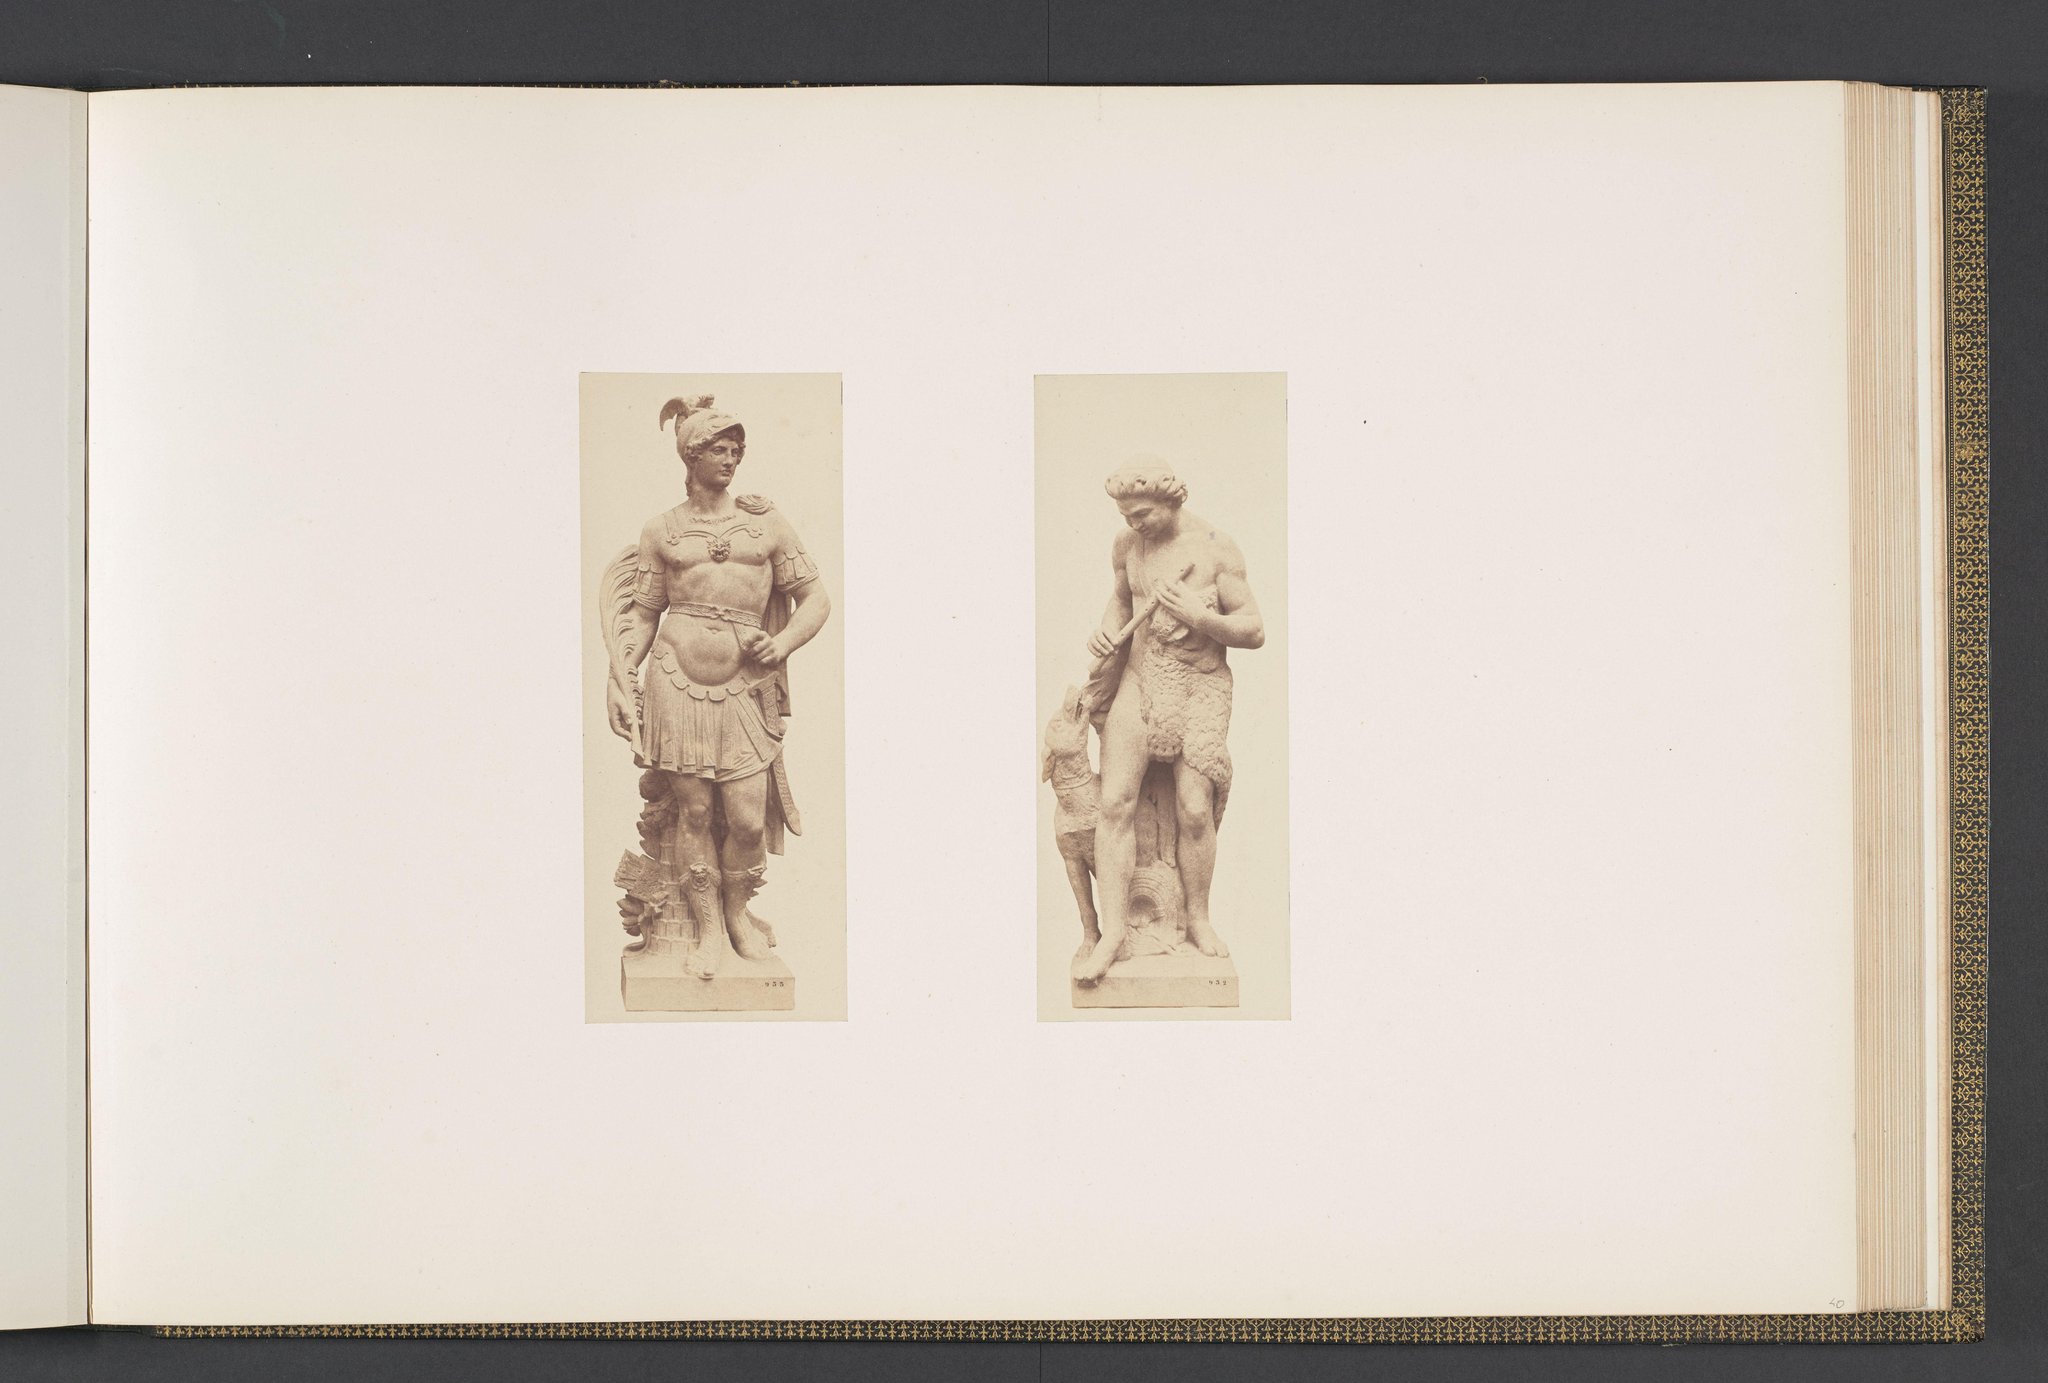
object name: photograph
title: Gipsmodellen voor beeldhouwwerken op het Palais du Louvre: links "Mars" door Jean Claude Petit en rechts "Le Joueur de flûte" door Armand Blanc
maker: édouard denis baldus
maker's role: fotograaf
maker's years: 1813-1889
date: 1855-1857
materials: paper, photographic support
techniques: salted paper print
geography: paris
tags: piece of sculpture, reproduction of a piece of sculpture, permanent exhibition, museum, paris, tuileries palace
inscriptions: number: ‘933 en 932’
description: Onderdeel van Réunion des Tuileries au Louvre 1852-1857, album 3.